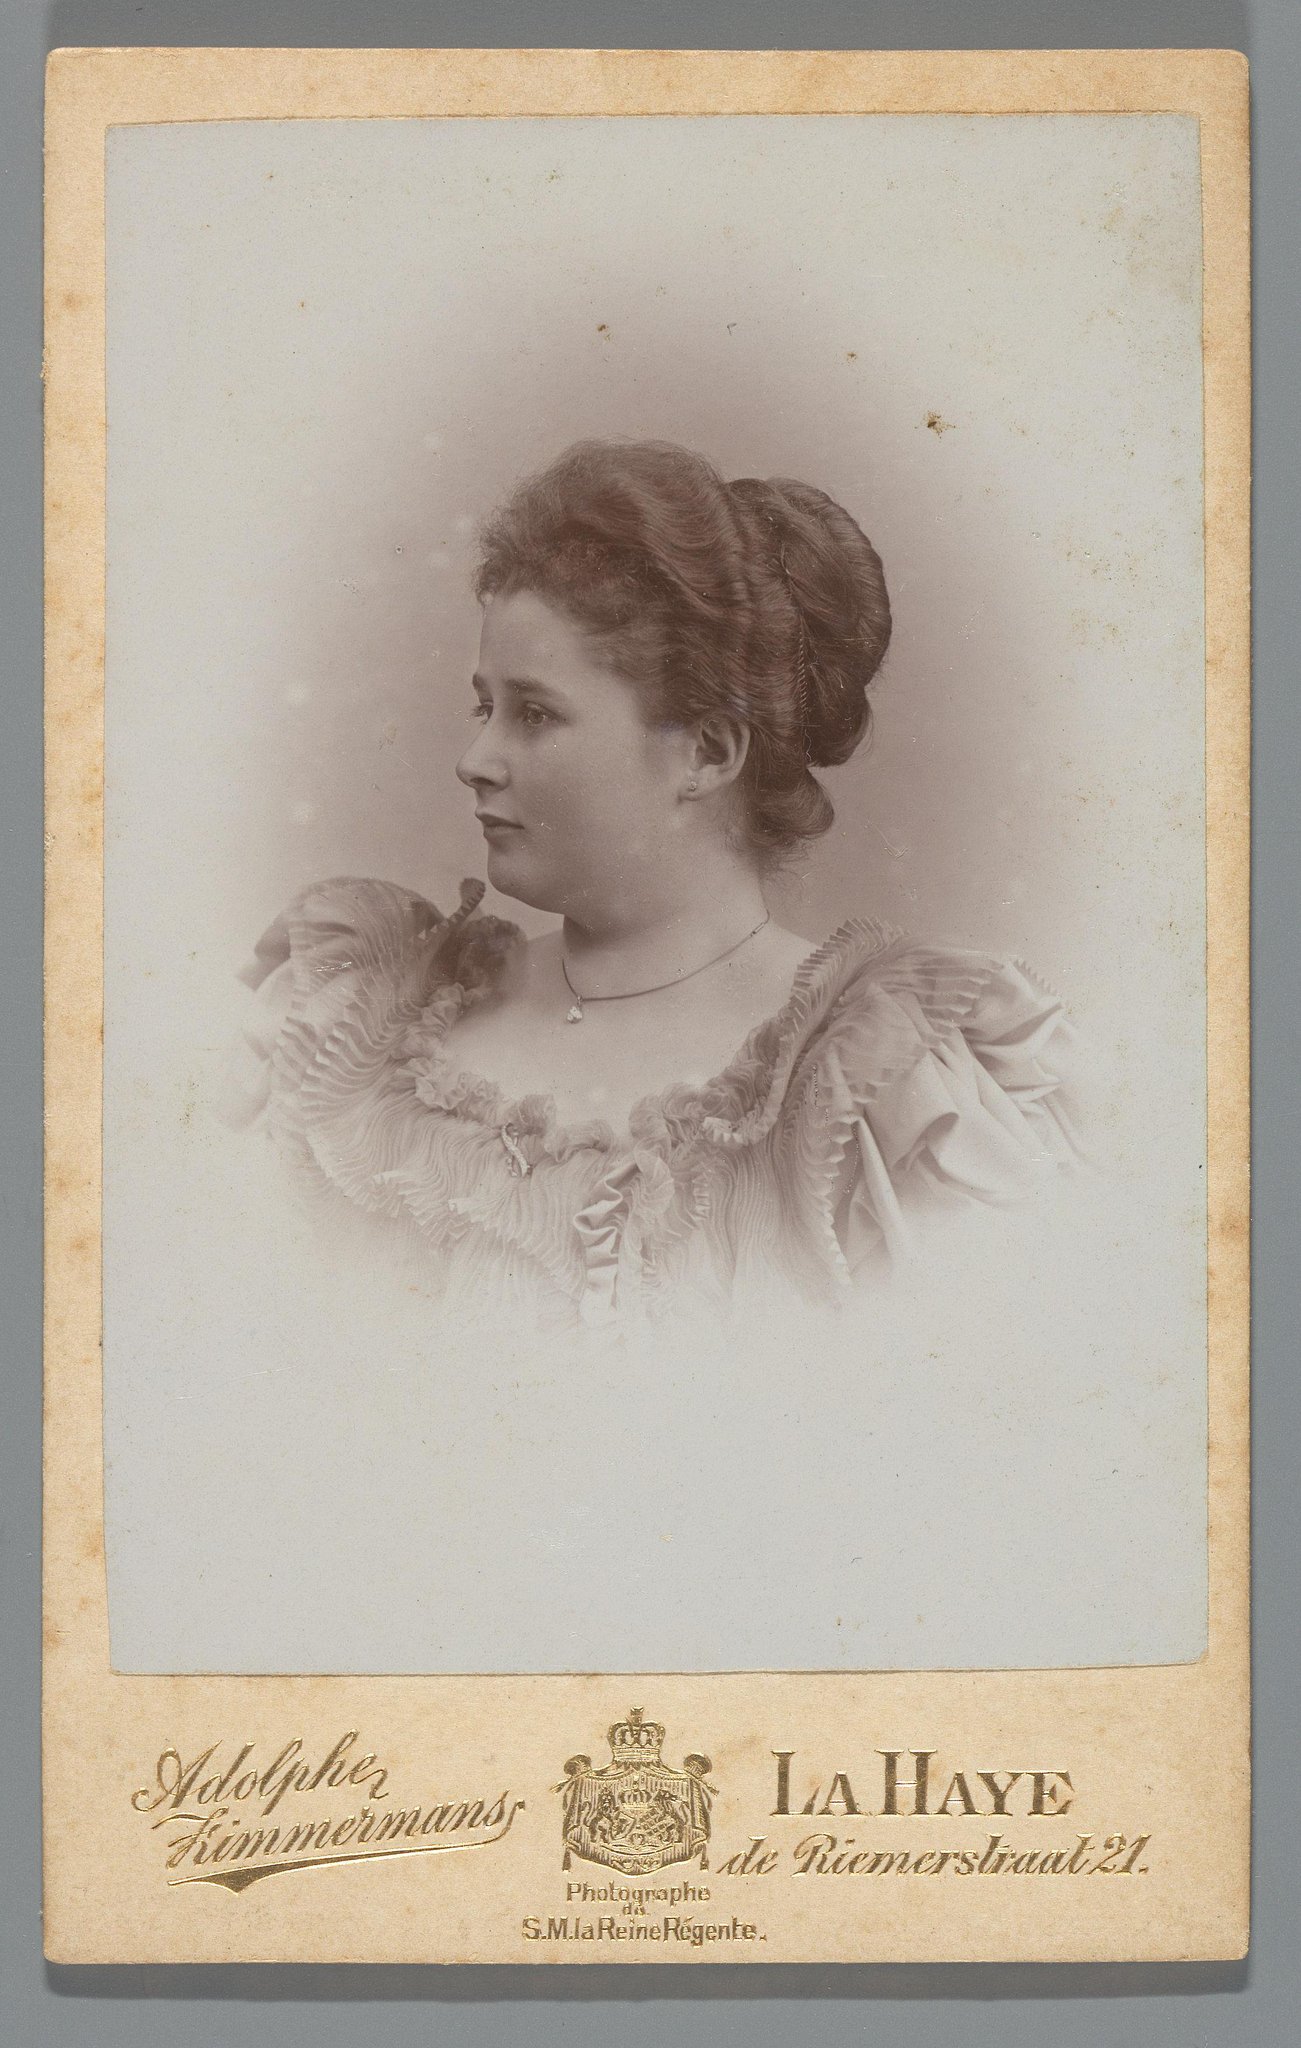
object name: photograph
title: Portret van Pauline Holle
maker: adolphe zimmermans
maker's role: fotograaf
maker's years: 1858-1922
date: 1870-1920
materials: cardboard, photographic support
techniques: albumen print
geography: the hague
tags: pauline brewer-holle (pau)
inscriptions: name: ‘Pauline Holle’, name: ‘Adolphe / Zimmermans / LA HAYE / de Riemer Straat 21.’